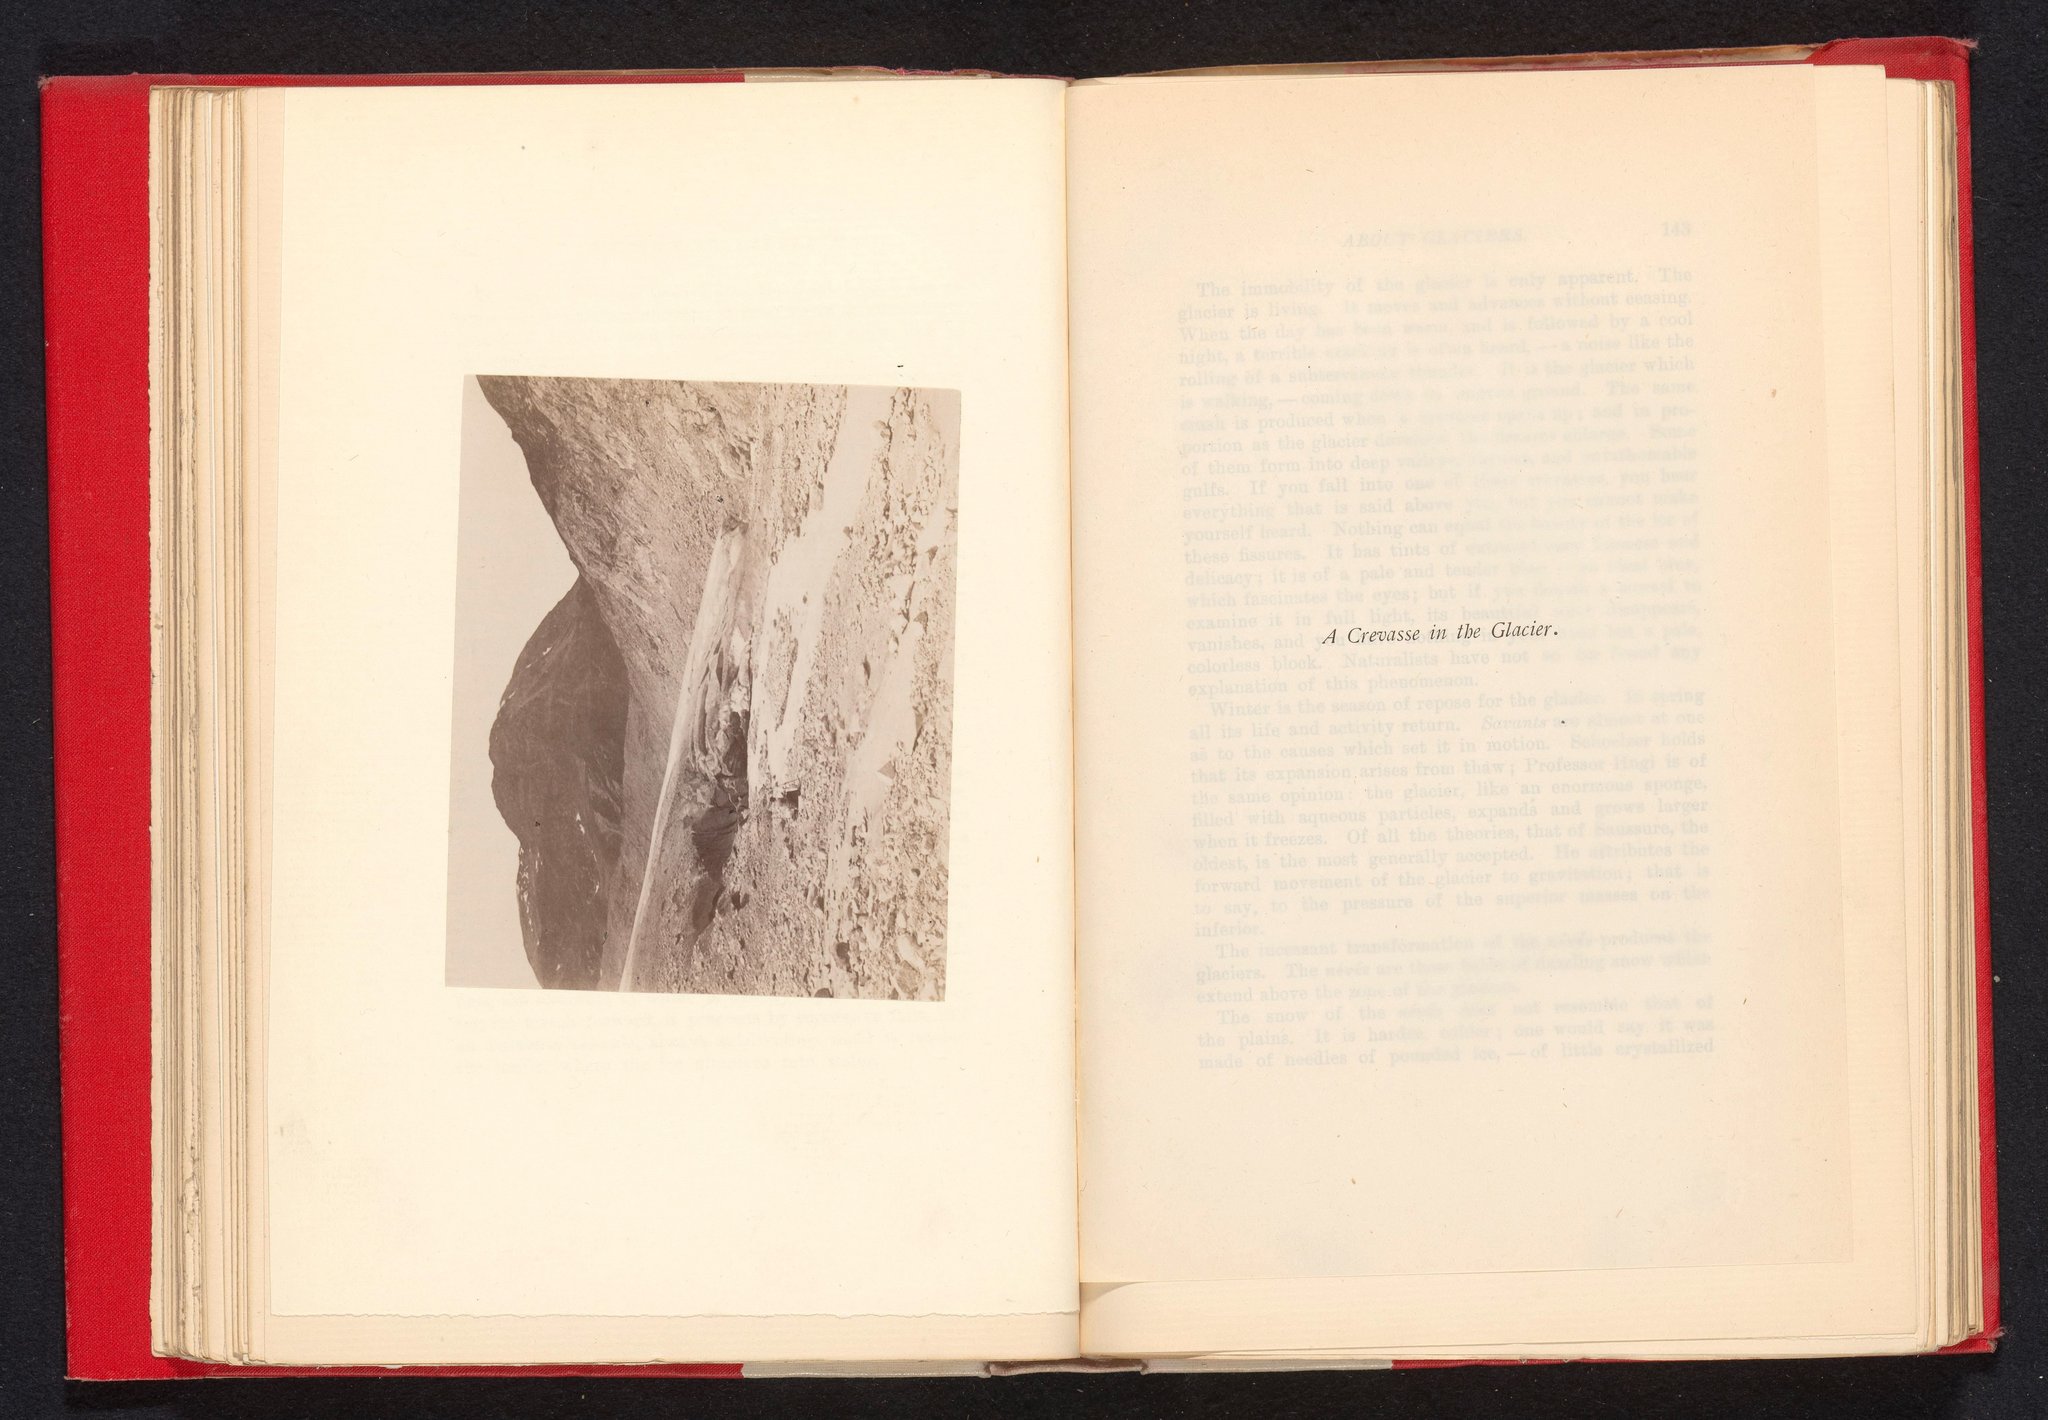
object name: photograph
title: A Crevasse in the Glacier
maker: Anonymous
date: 1879-1889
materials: photographic support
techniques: albumen print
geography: switzerland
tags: glacier, mountains